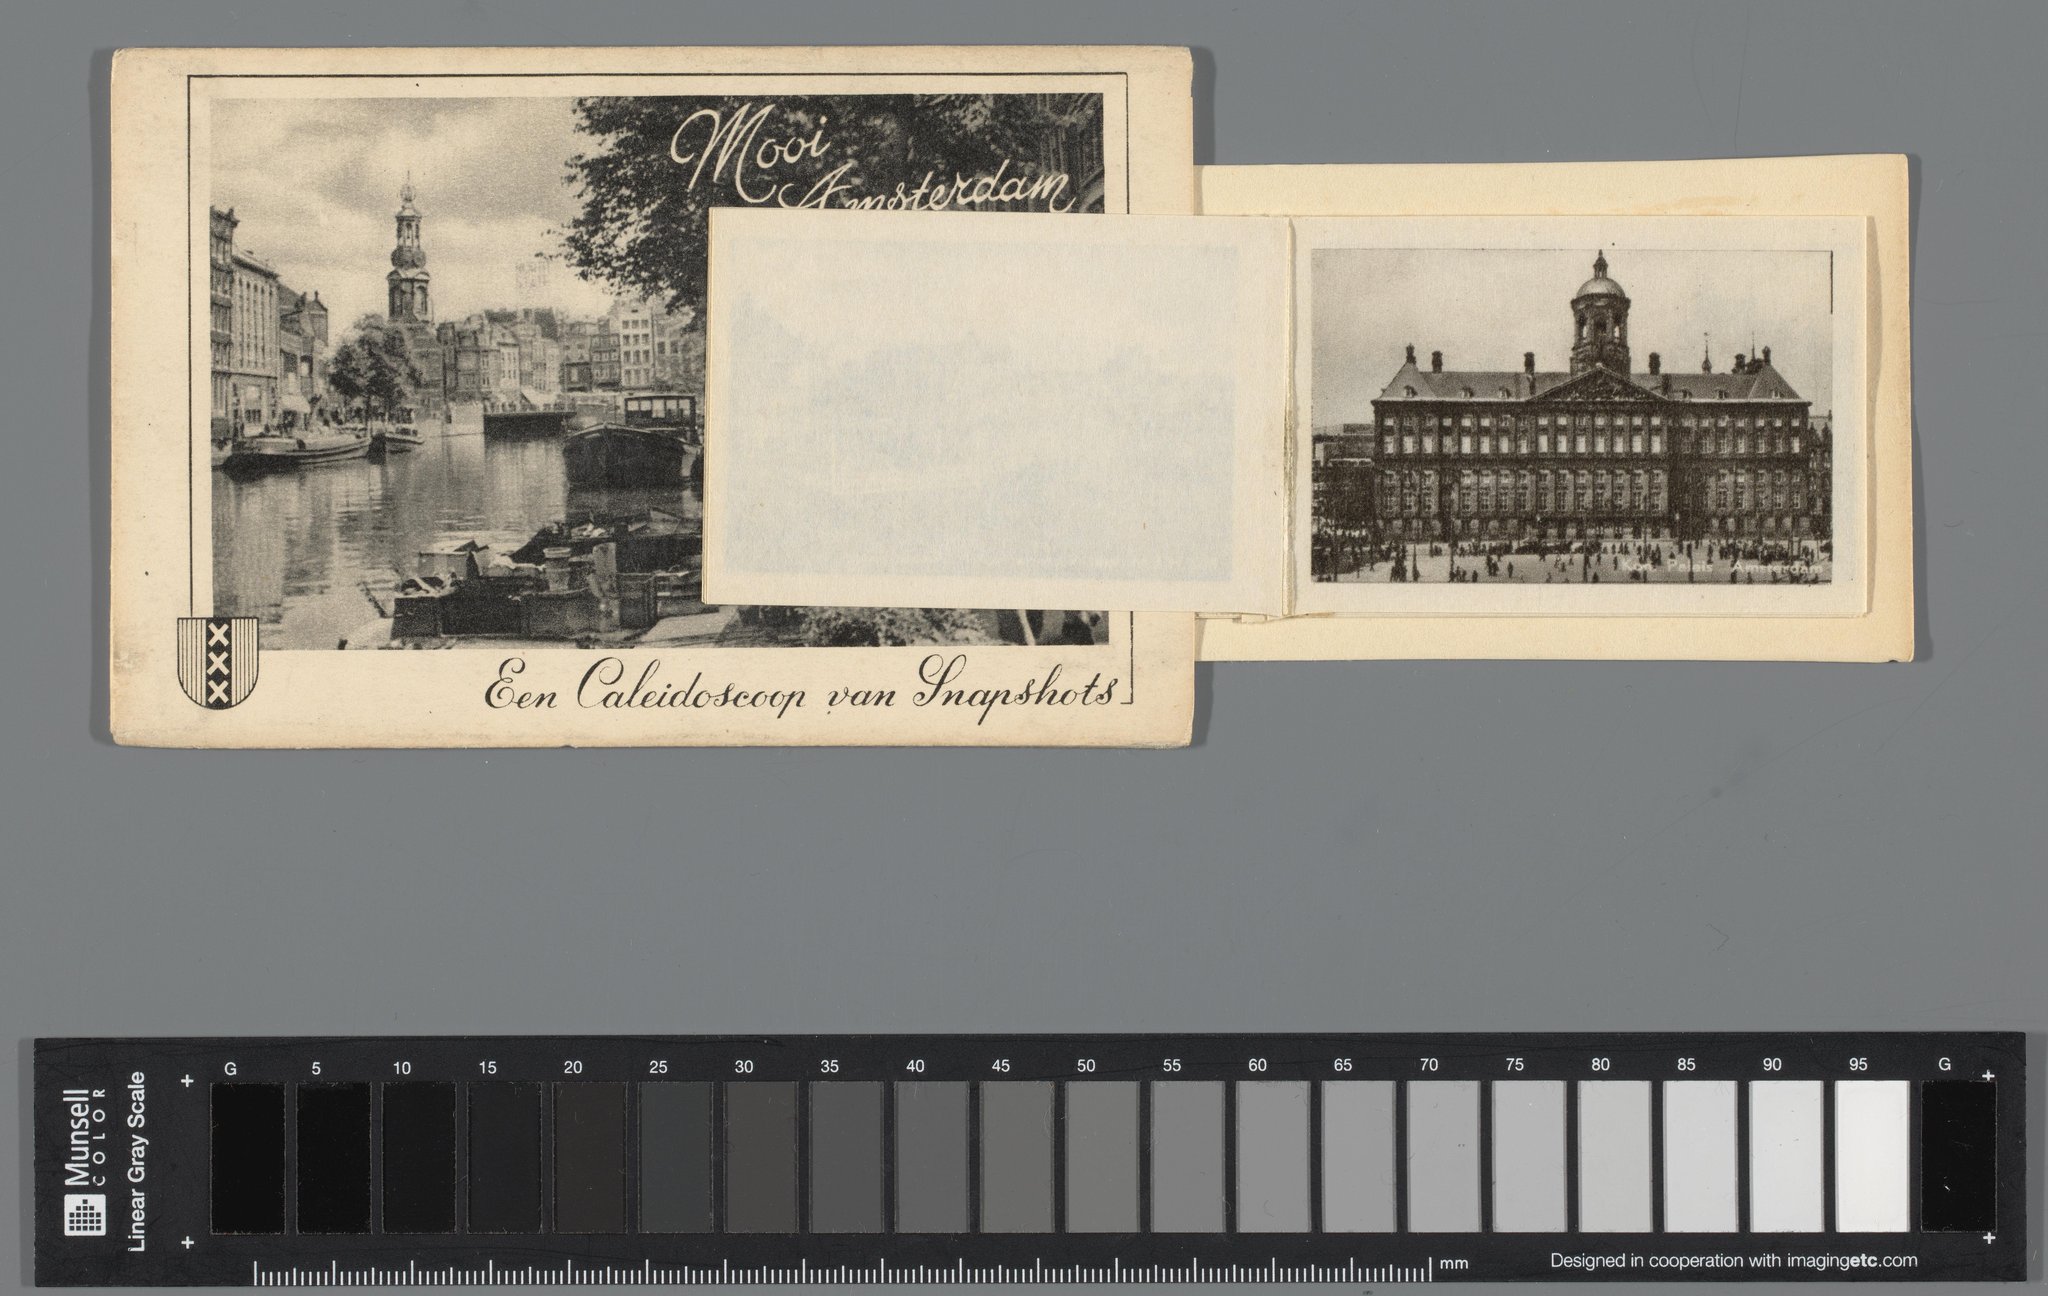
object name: photomechanical print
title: Kon. Paleis Amsterdam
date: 1920-1950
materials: paper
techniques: rotogravure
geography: eemnes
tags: square, place, circus, etc., palace, royal palace of amsterdam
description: Deze prent maakt deel uit van een omslag met tien prenten.